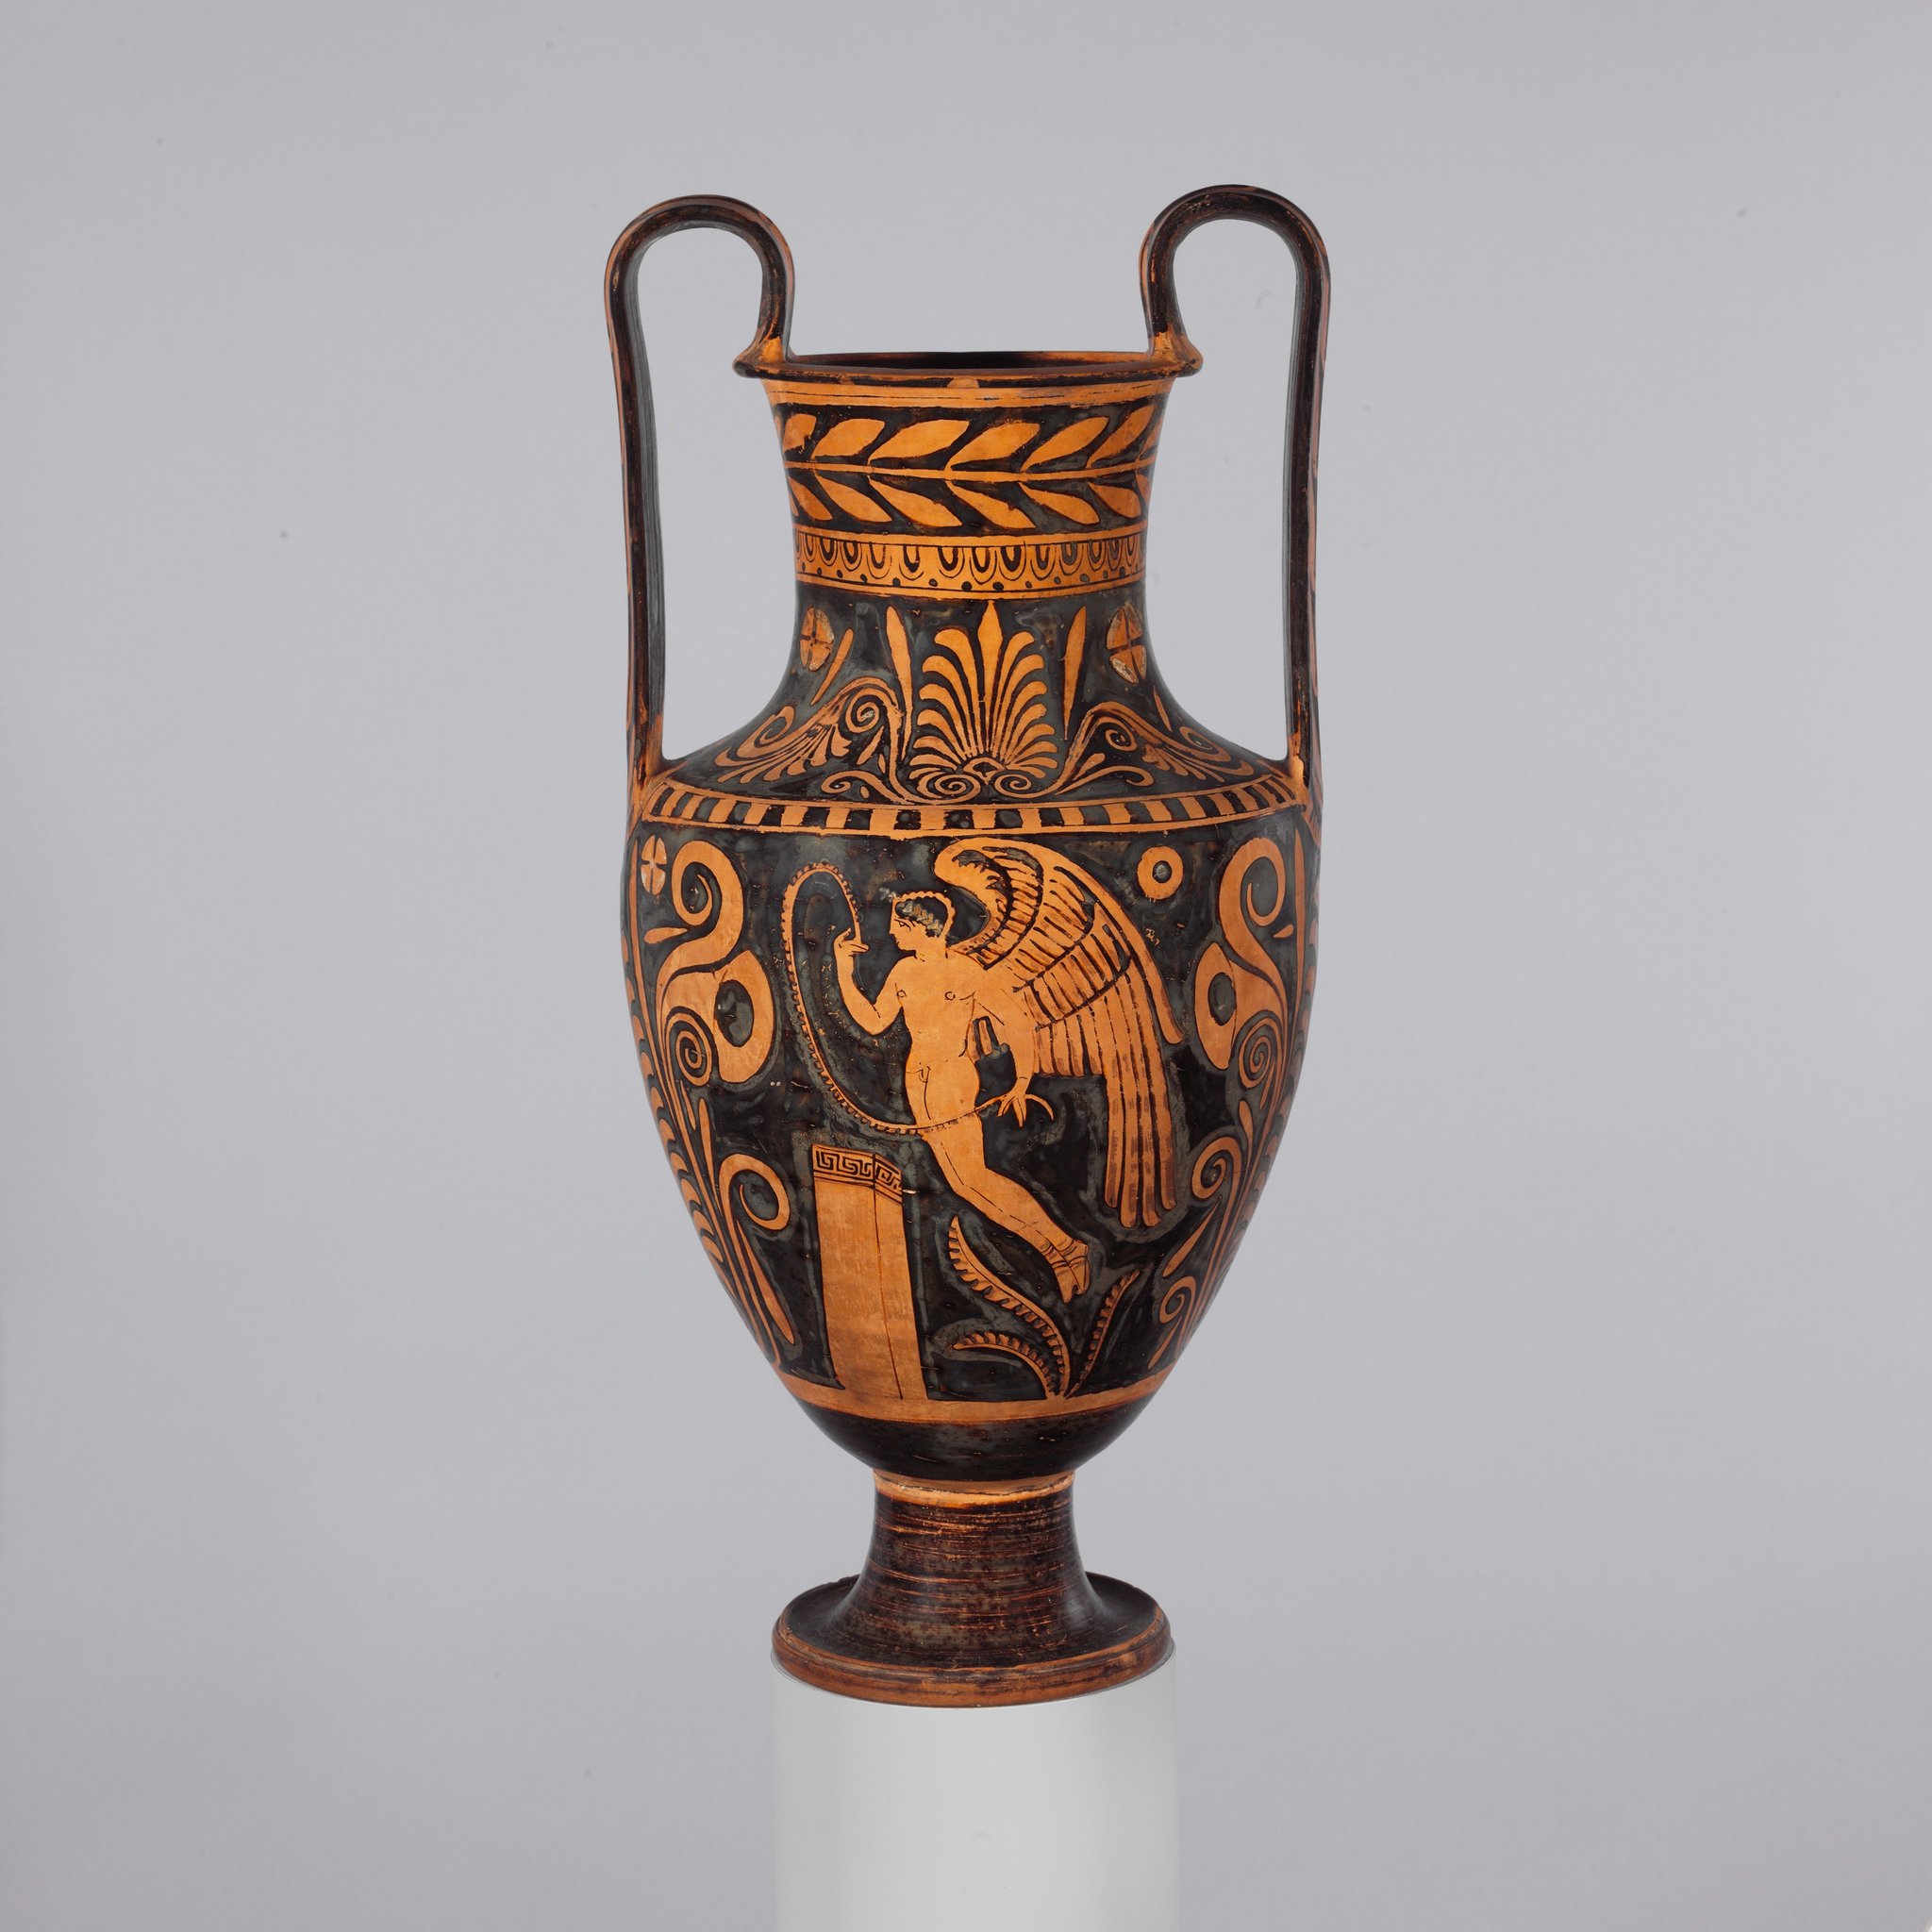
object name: nestoris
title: Terracotta nestoris (two-handled jar)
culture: greek, south italian, lucanian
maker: primato painter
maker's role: artist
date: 350-325 BCE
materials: terracotta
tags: male nudes,eros